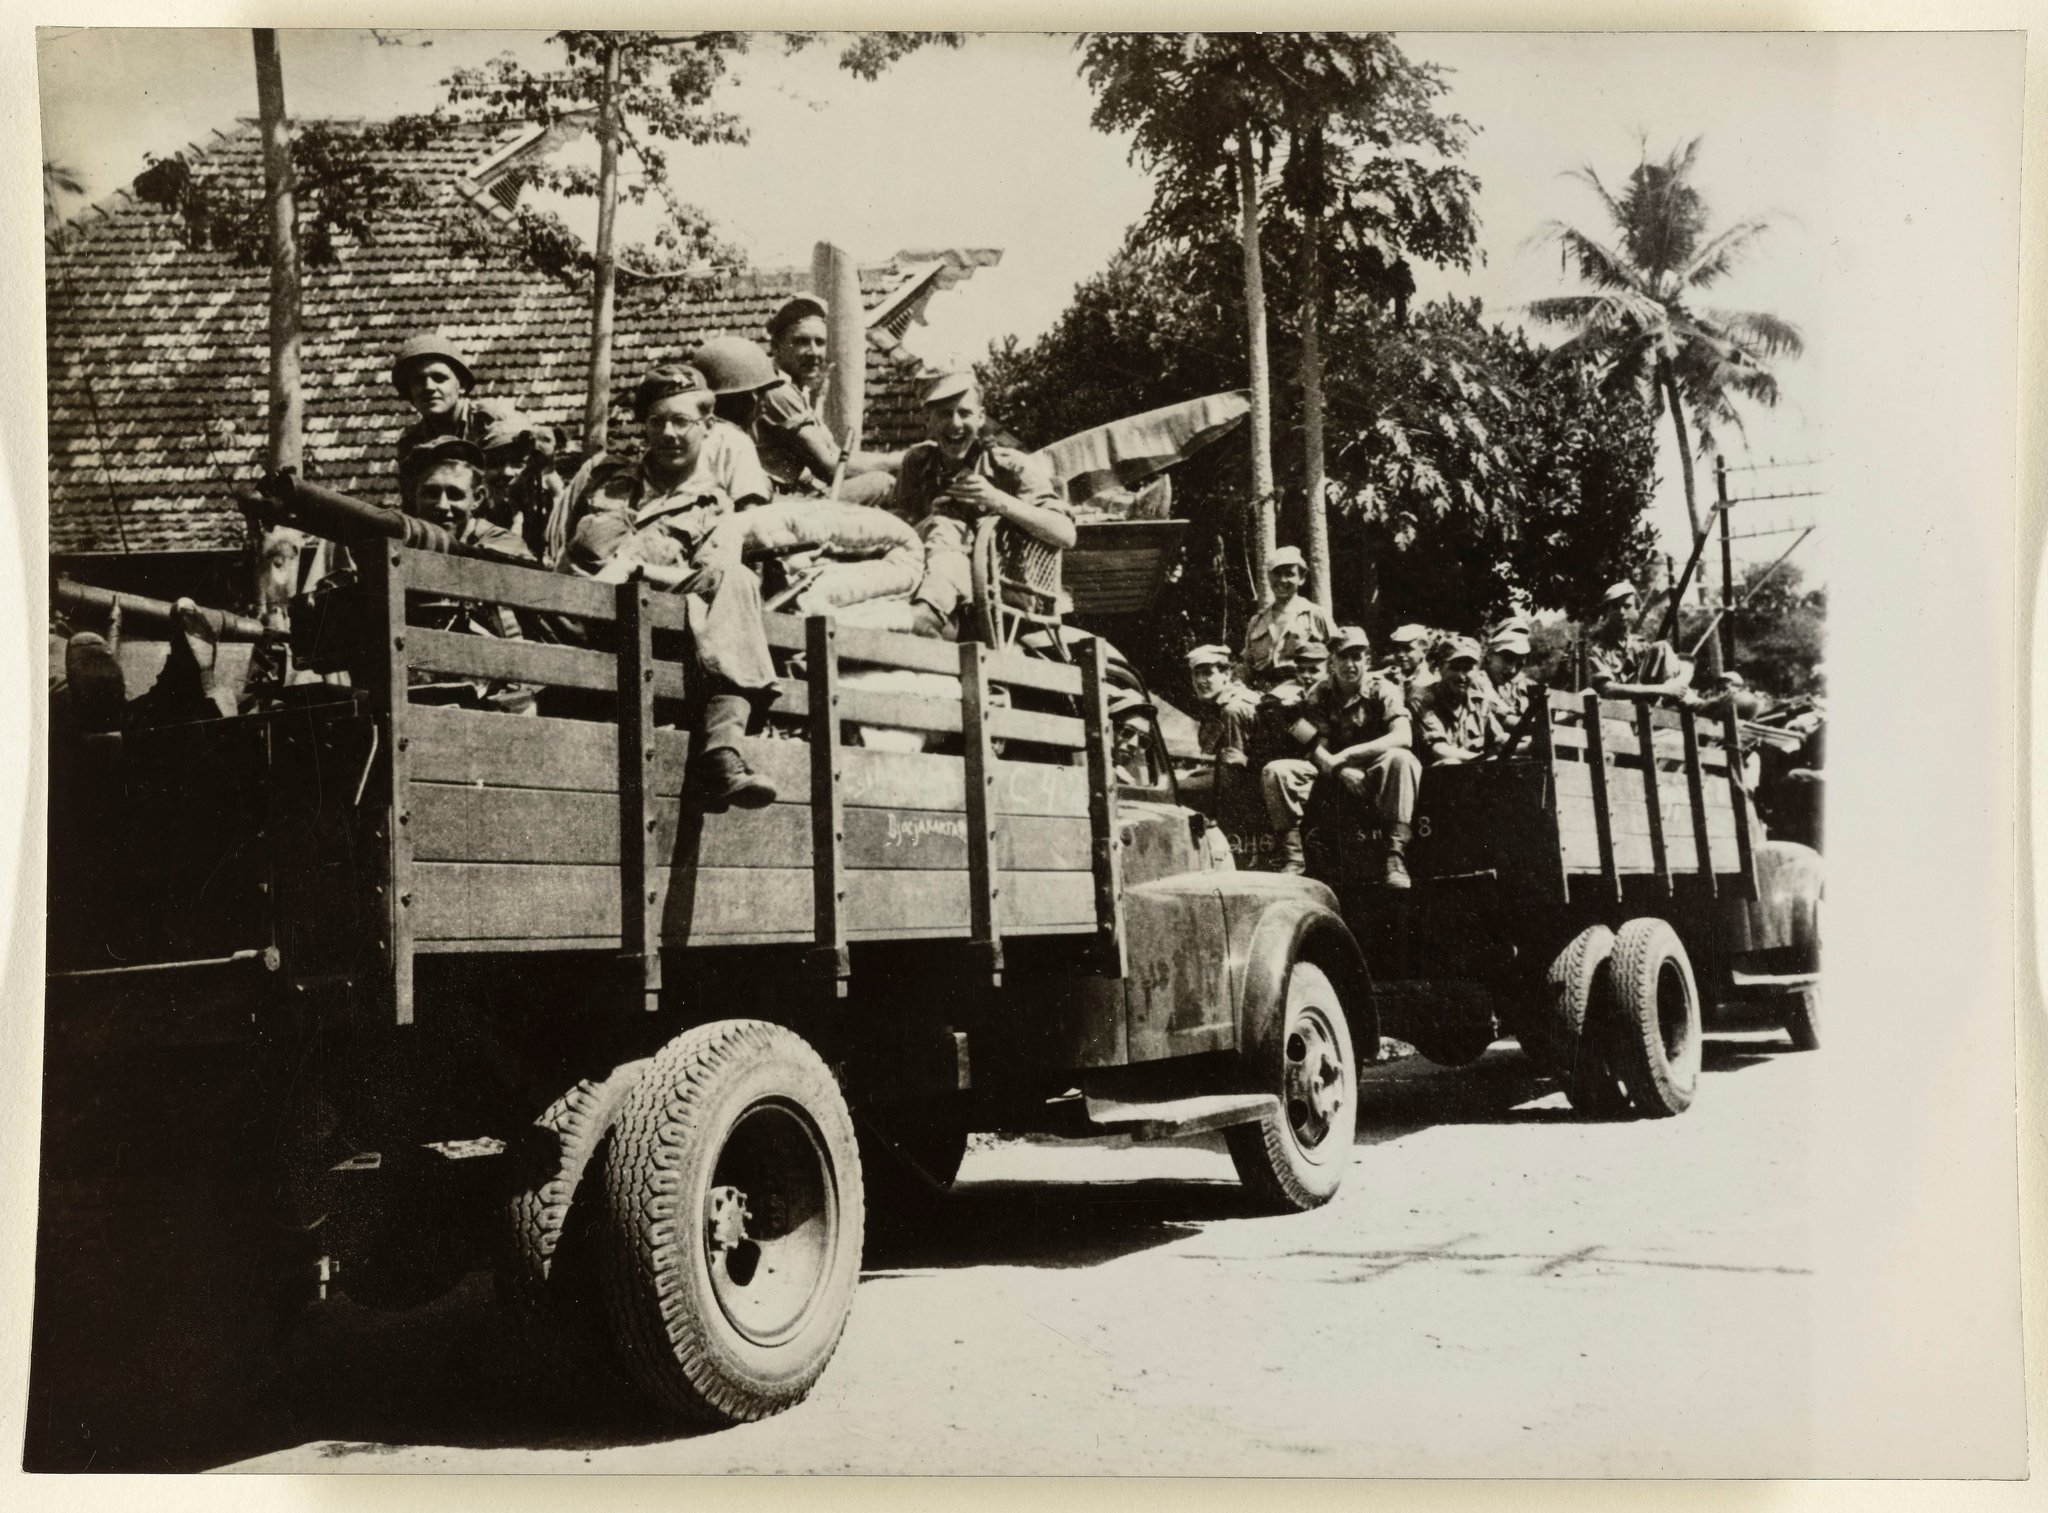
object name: documentary photograph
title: Nederlandse troepen trekken zich terug uit Jogyakarta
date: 1906-1947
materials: photographic support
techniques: photography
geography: jogjakarta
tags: ons vrije nederland, jogjakarta, onafhankelijkheid indonesië, nederlandse militaire acties in indonesië (1945-1949)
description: Twee open vrachtwagens gevuld met Nederlandse militairen en wapens vertrekken gedwongen uit Jogyakarta. De stad werd ingenomen door de Indonesische guerillas onder leiding van Sultan Hamengku Buwono.